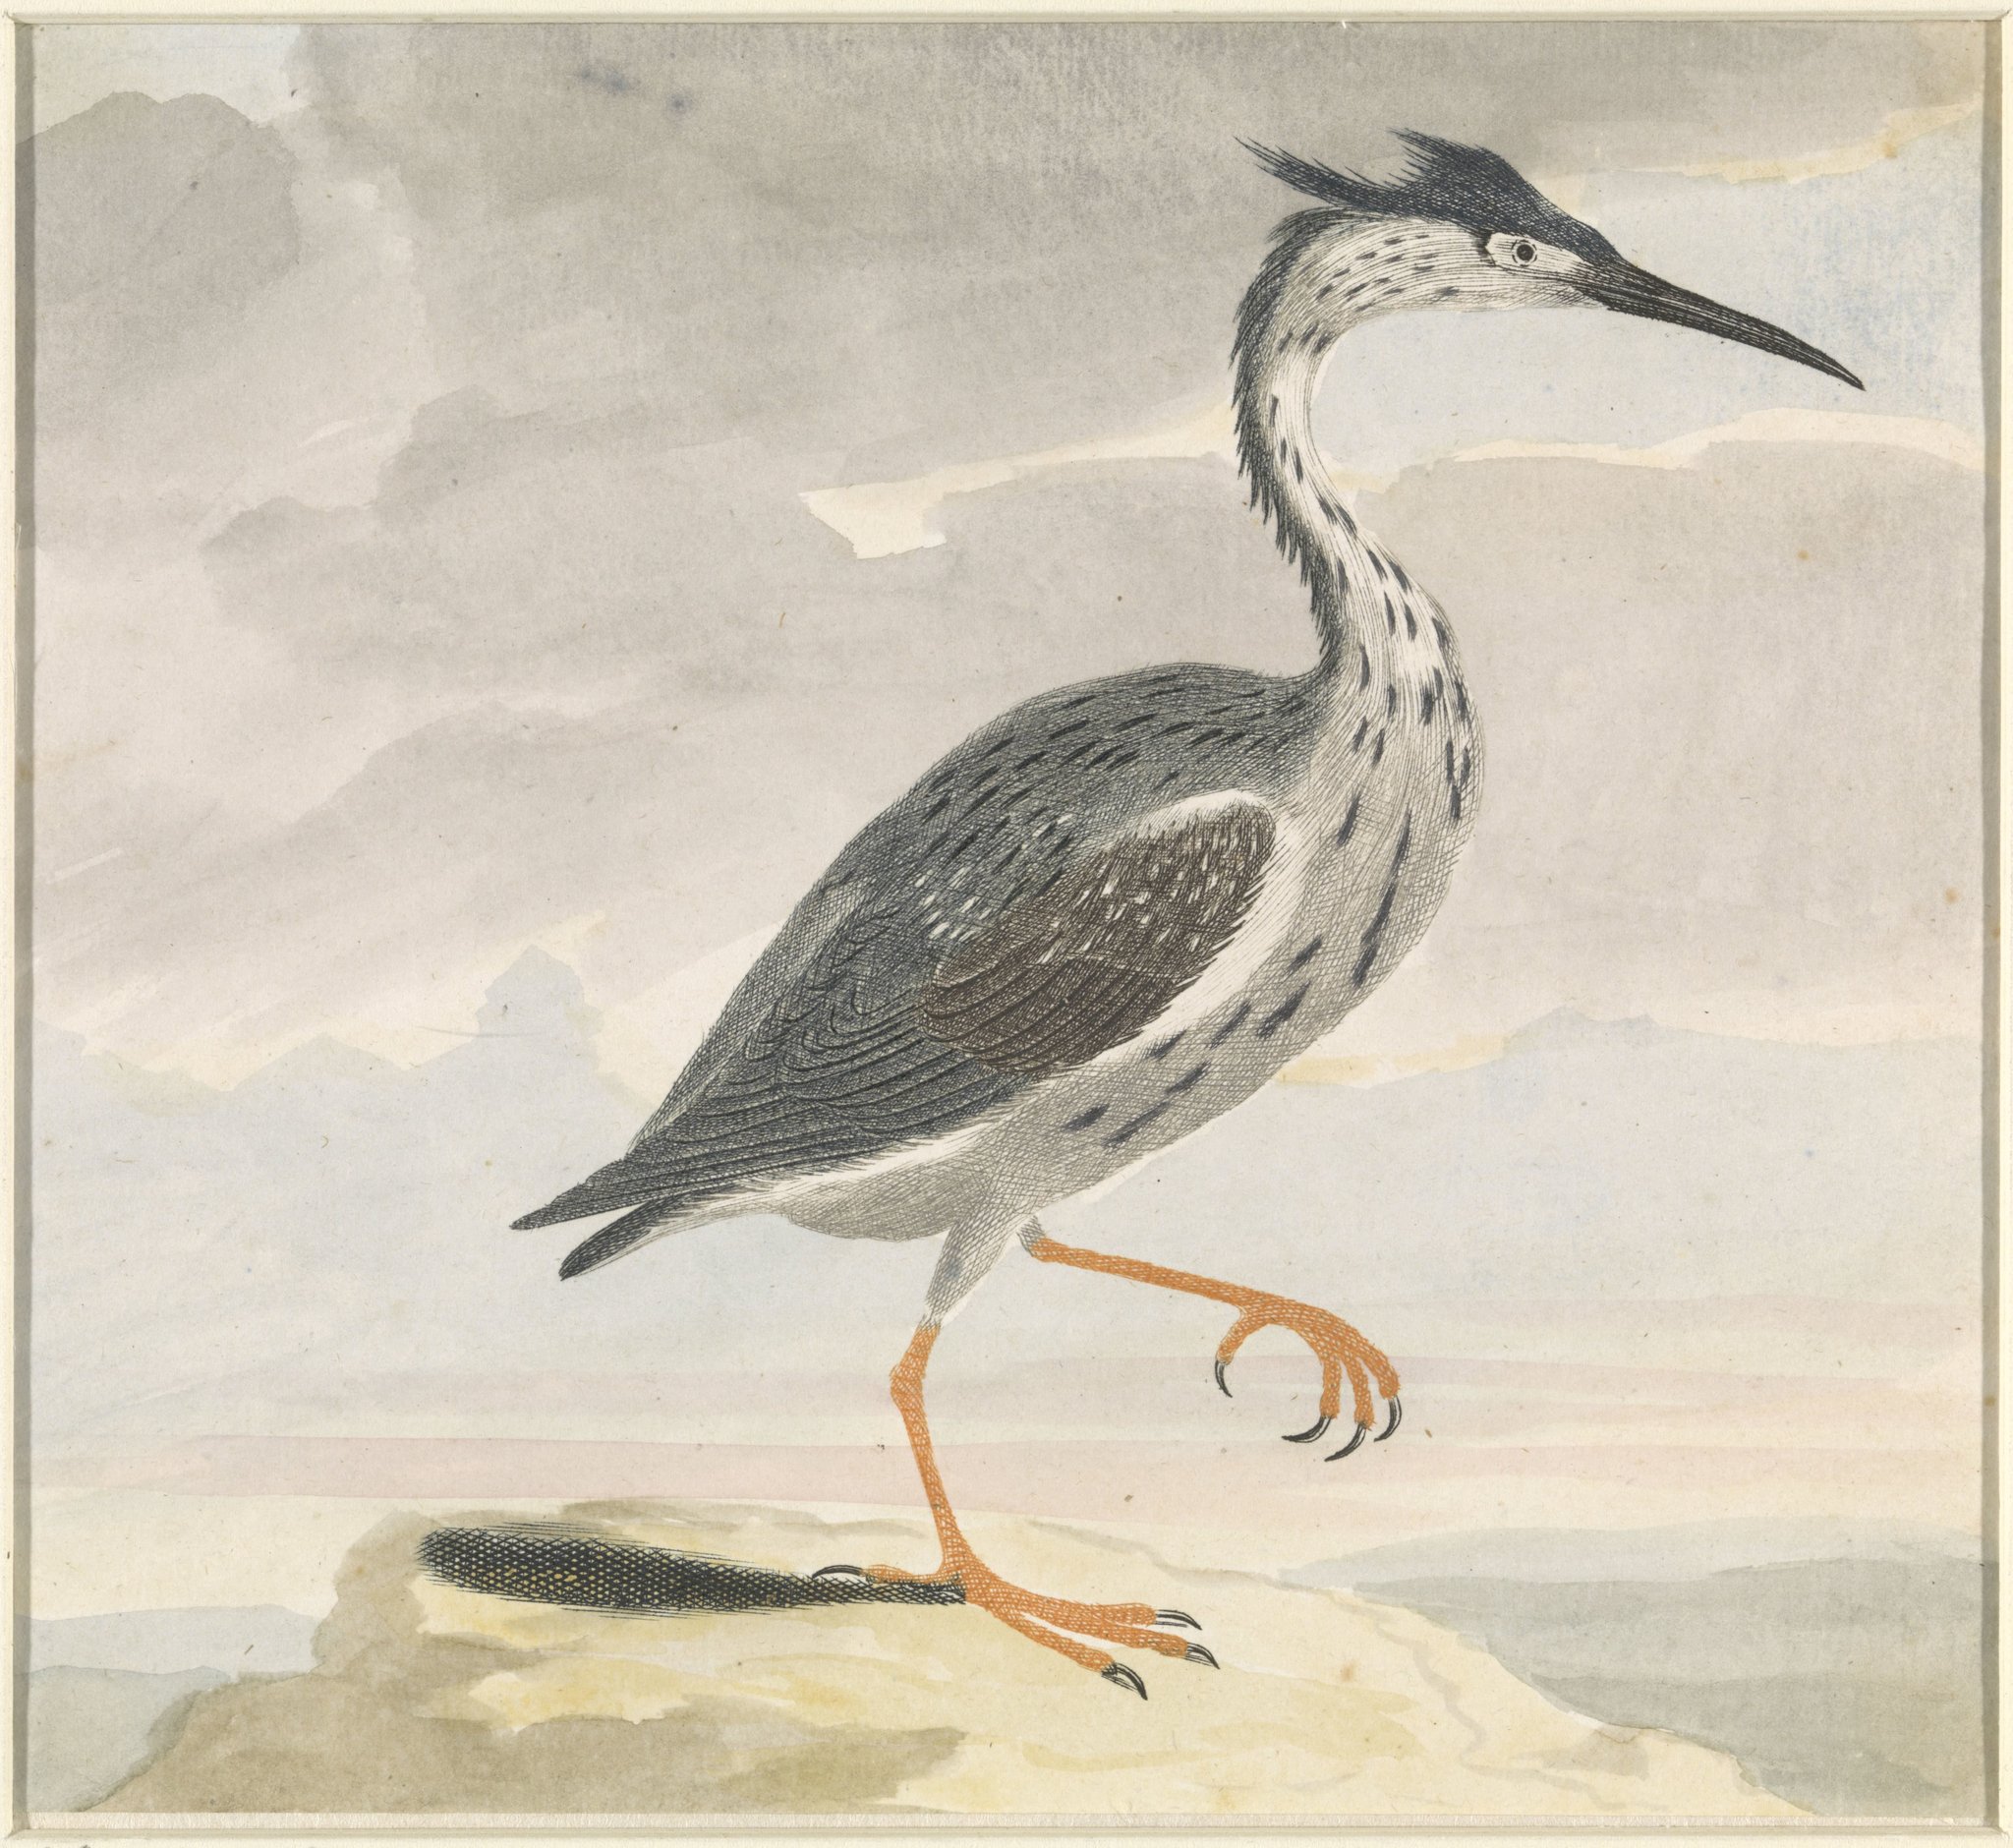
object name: print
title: Reiger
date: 1688-1698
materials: paper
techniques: printing, engraving, hand coloring, lithography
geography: netherlands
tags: shore-birds and wading-birds: heron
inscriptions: collector's mark: Lugt 2760, collector's mark: Lugt 2228